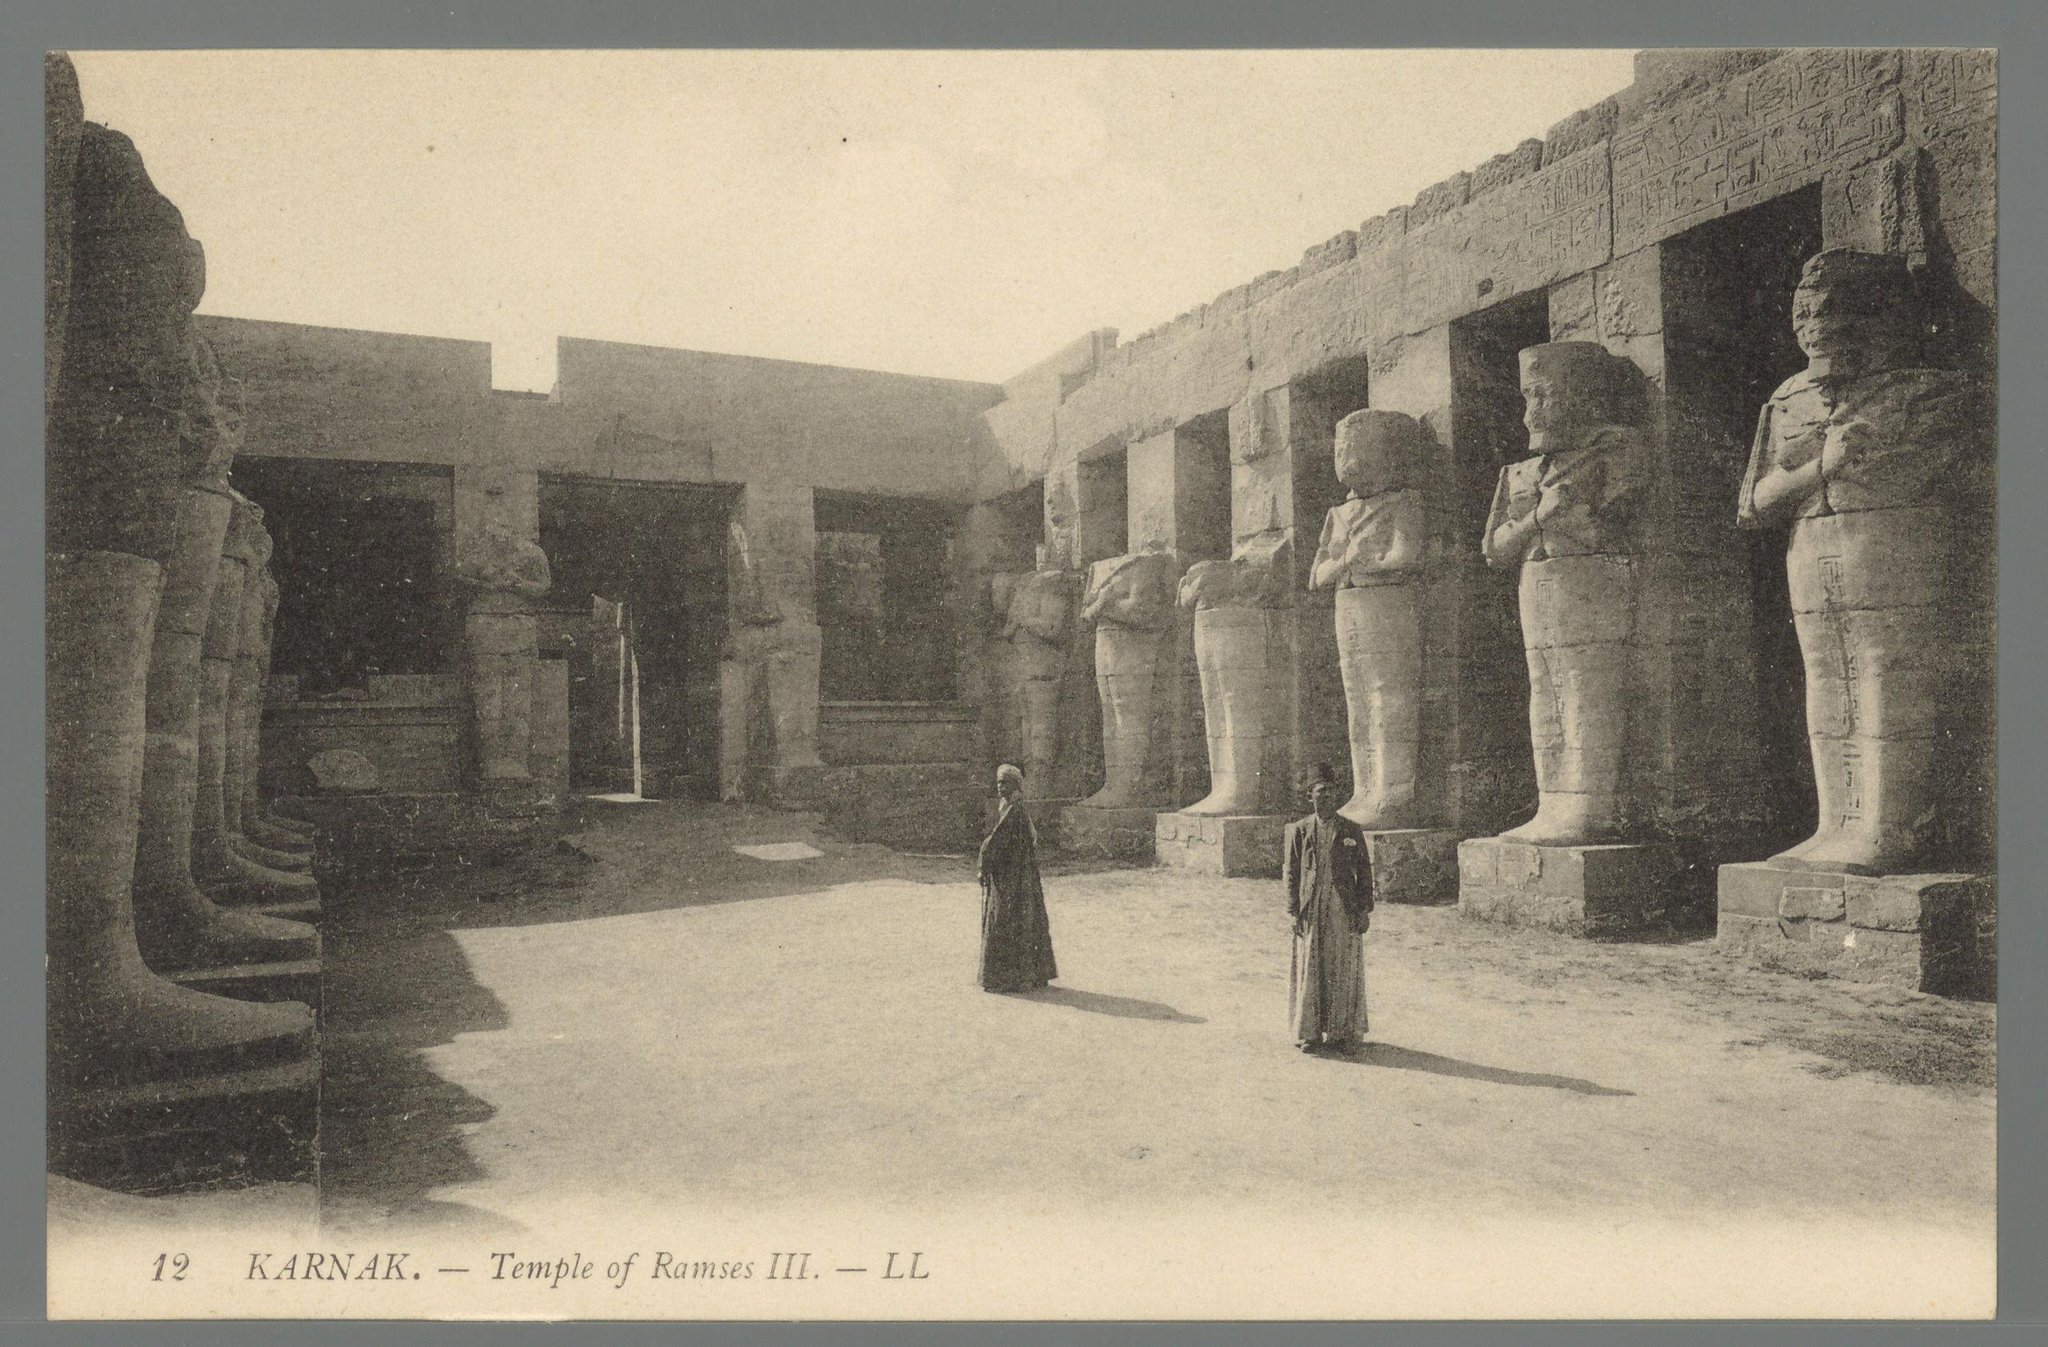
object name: photomechanical print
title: Karnak - Temple of Ramses III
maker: Anonymous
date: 1907-1930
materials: cardboard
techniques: photograph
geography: paris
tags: temple, shrine ~ egyptian religion, statues, paintings, etc. ~ objects of worship (egyptian religion)